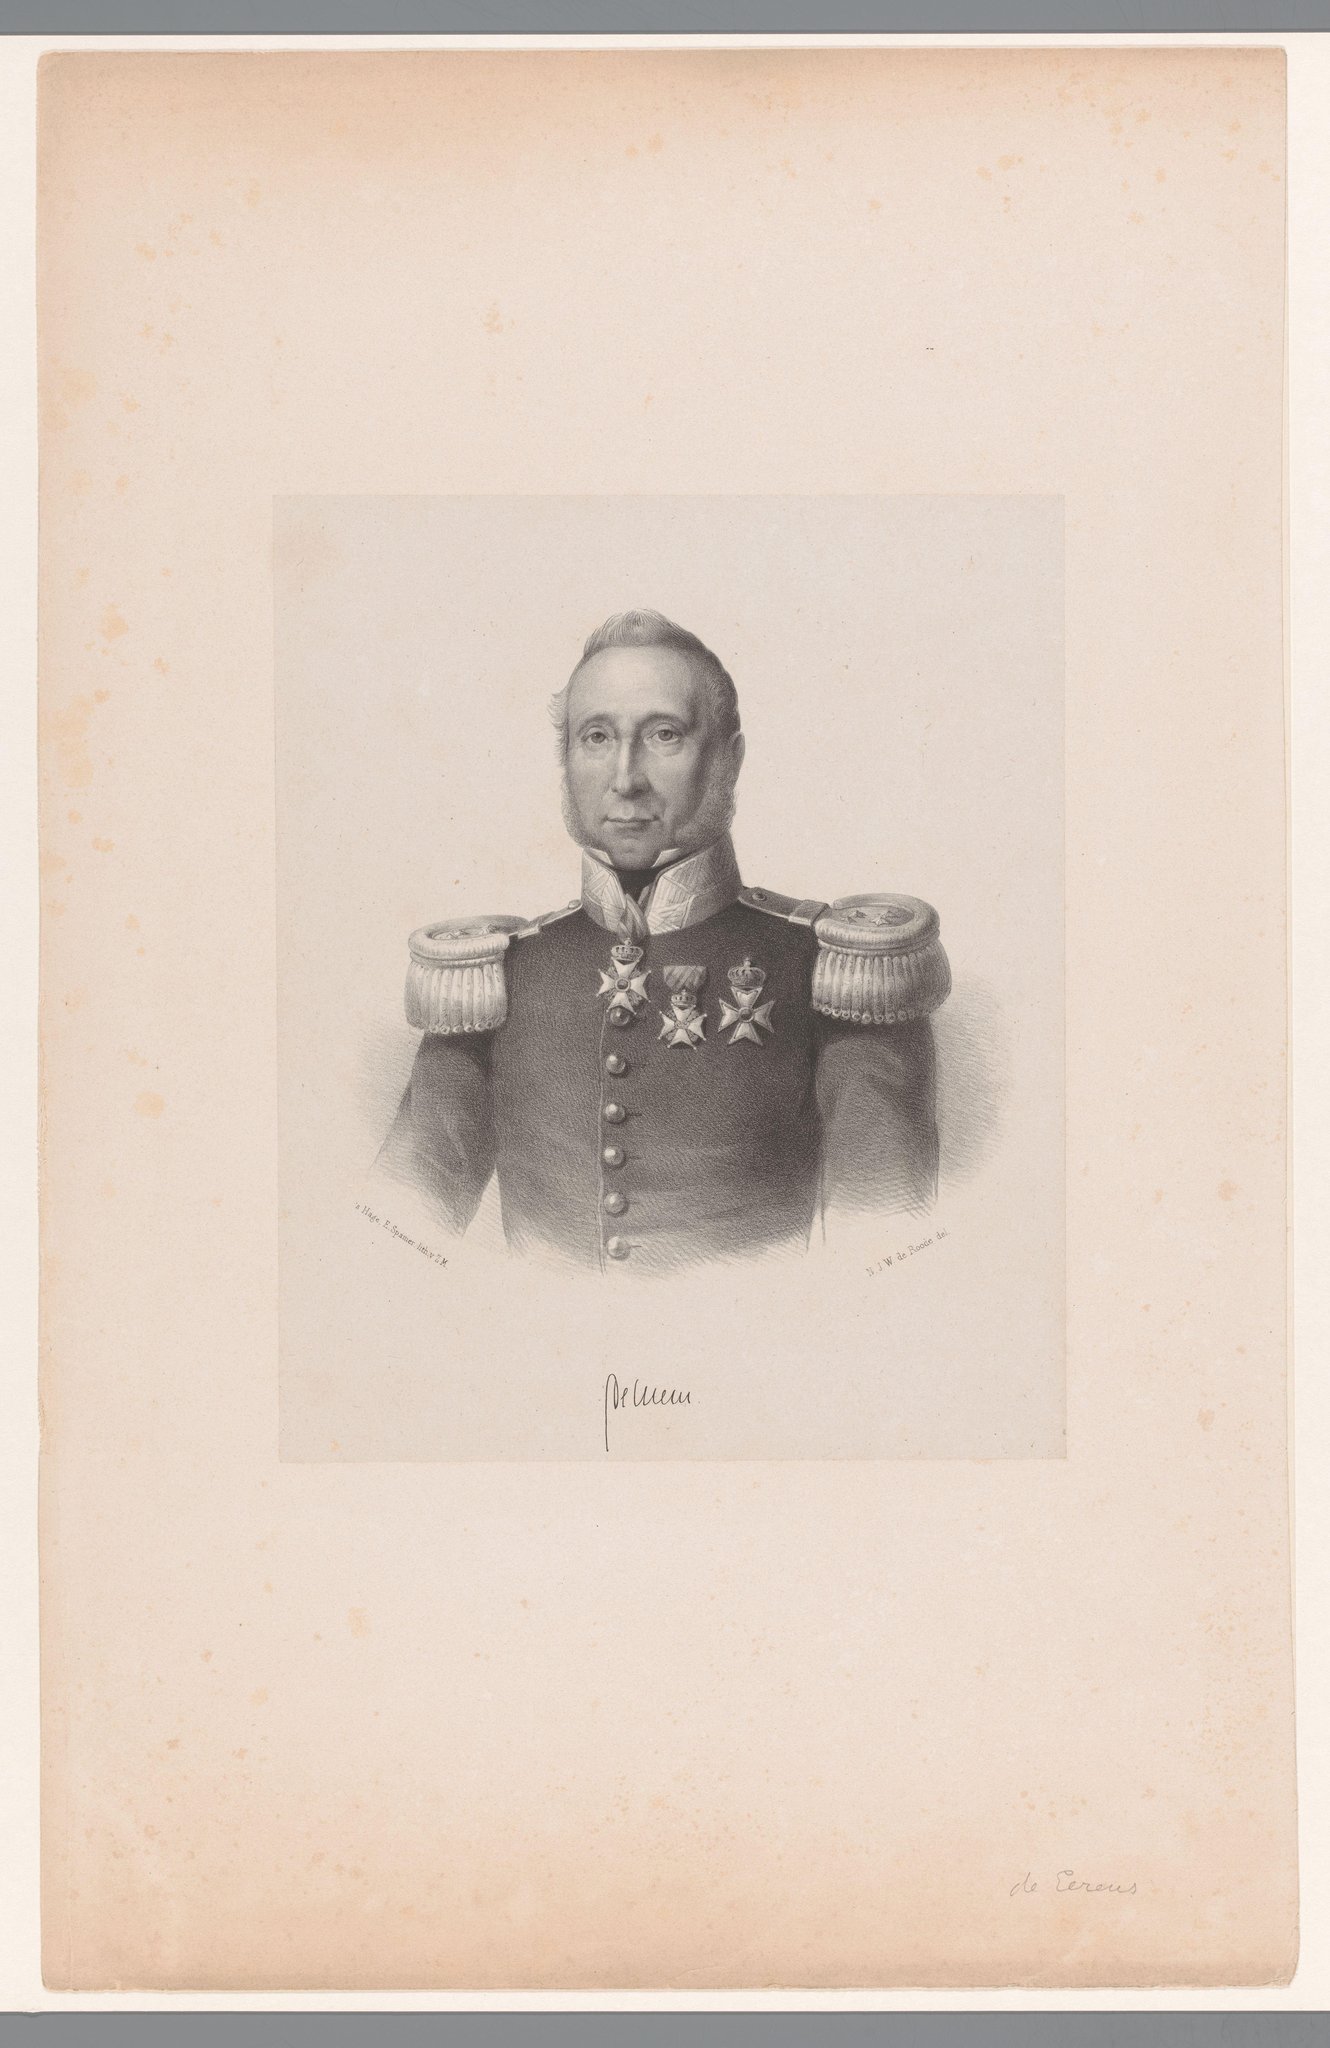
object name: print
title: Portret van Dominique Jacques de Eerens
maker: elias spanier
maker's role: print maker, printer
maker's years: 1821-1863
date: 1831-1840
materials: paper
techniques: lithograph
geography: the hague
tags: historical persons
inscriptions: collector's mark: Lugt 2228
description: Onder het portret de signatuur van de geportretteerde.